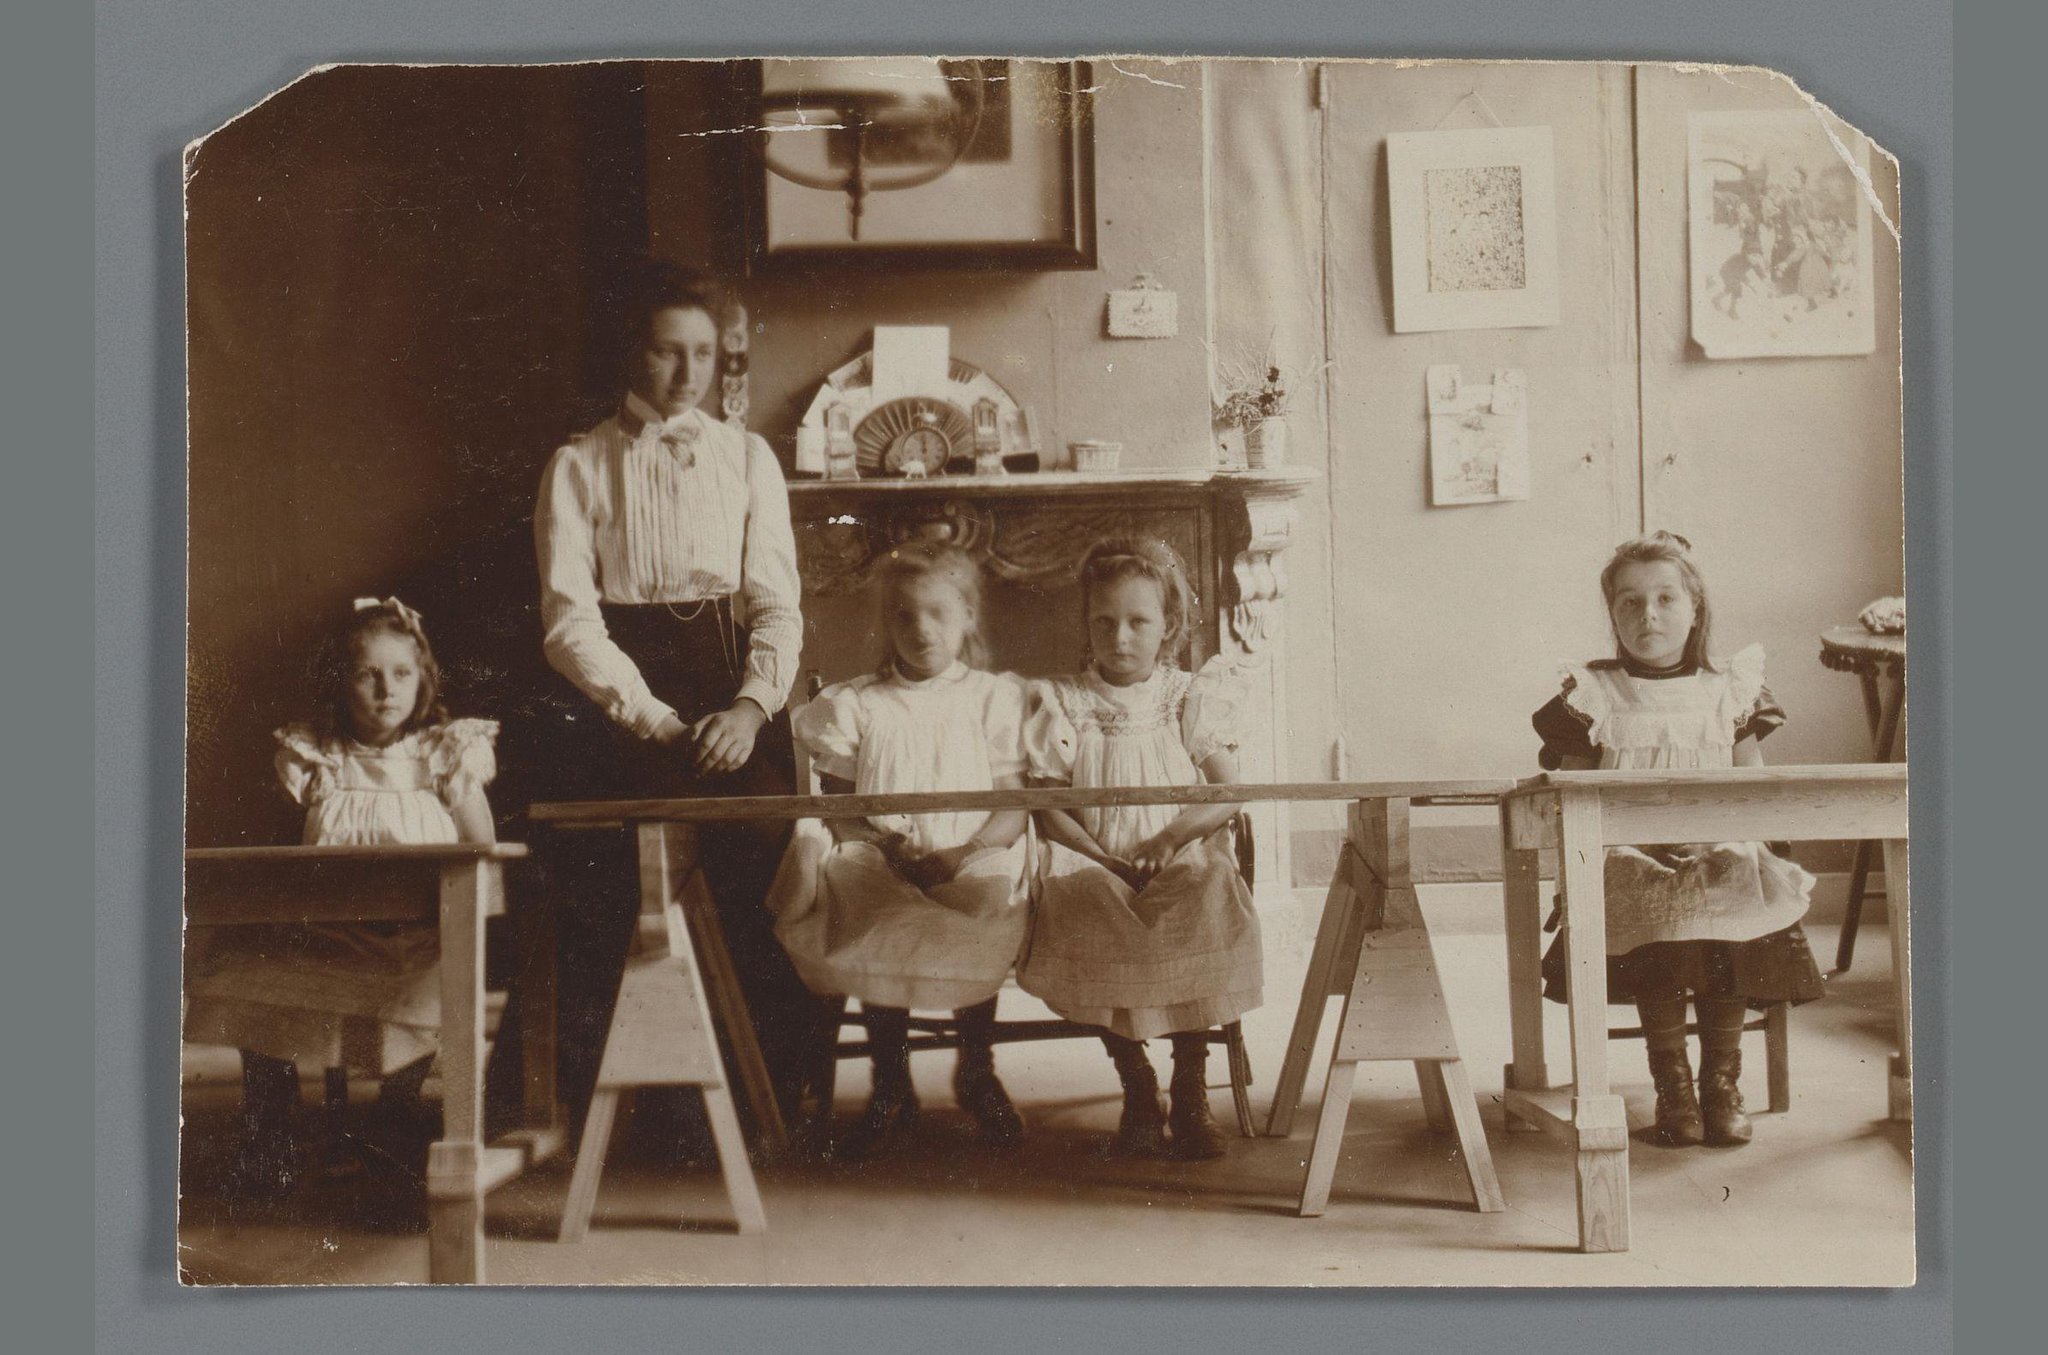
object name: photograph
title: Johanna (Hans) de Jong met klasgenoten en lerares op de lagere school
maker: willem de jong (fotograaf)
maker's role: arts, fotograaf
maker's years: 1864-1918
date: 1901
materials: paper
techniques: collodion silver print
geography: leiden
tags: johanna petronella lambertina stokhuyzen-de jong (hans), historical persons not known by name - bb - woman, teacher and pupil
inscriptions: inscription: ‘Suus v. Gelder/ Mies Wijsma/ Lotte/ MacGillaway/ Phien Coesbergh/ H.’, date: ‘1901’, inscription: ‘Suus/ part. school/ Ivan [...] v Jan [...]/ moeder ook/ [...])’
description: De meisjes met Johanna (Hans) de Jong zijn Lotte MacGillaway, Suus van Gelder, Mies Wijsman en Phien Coeberg.